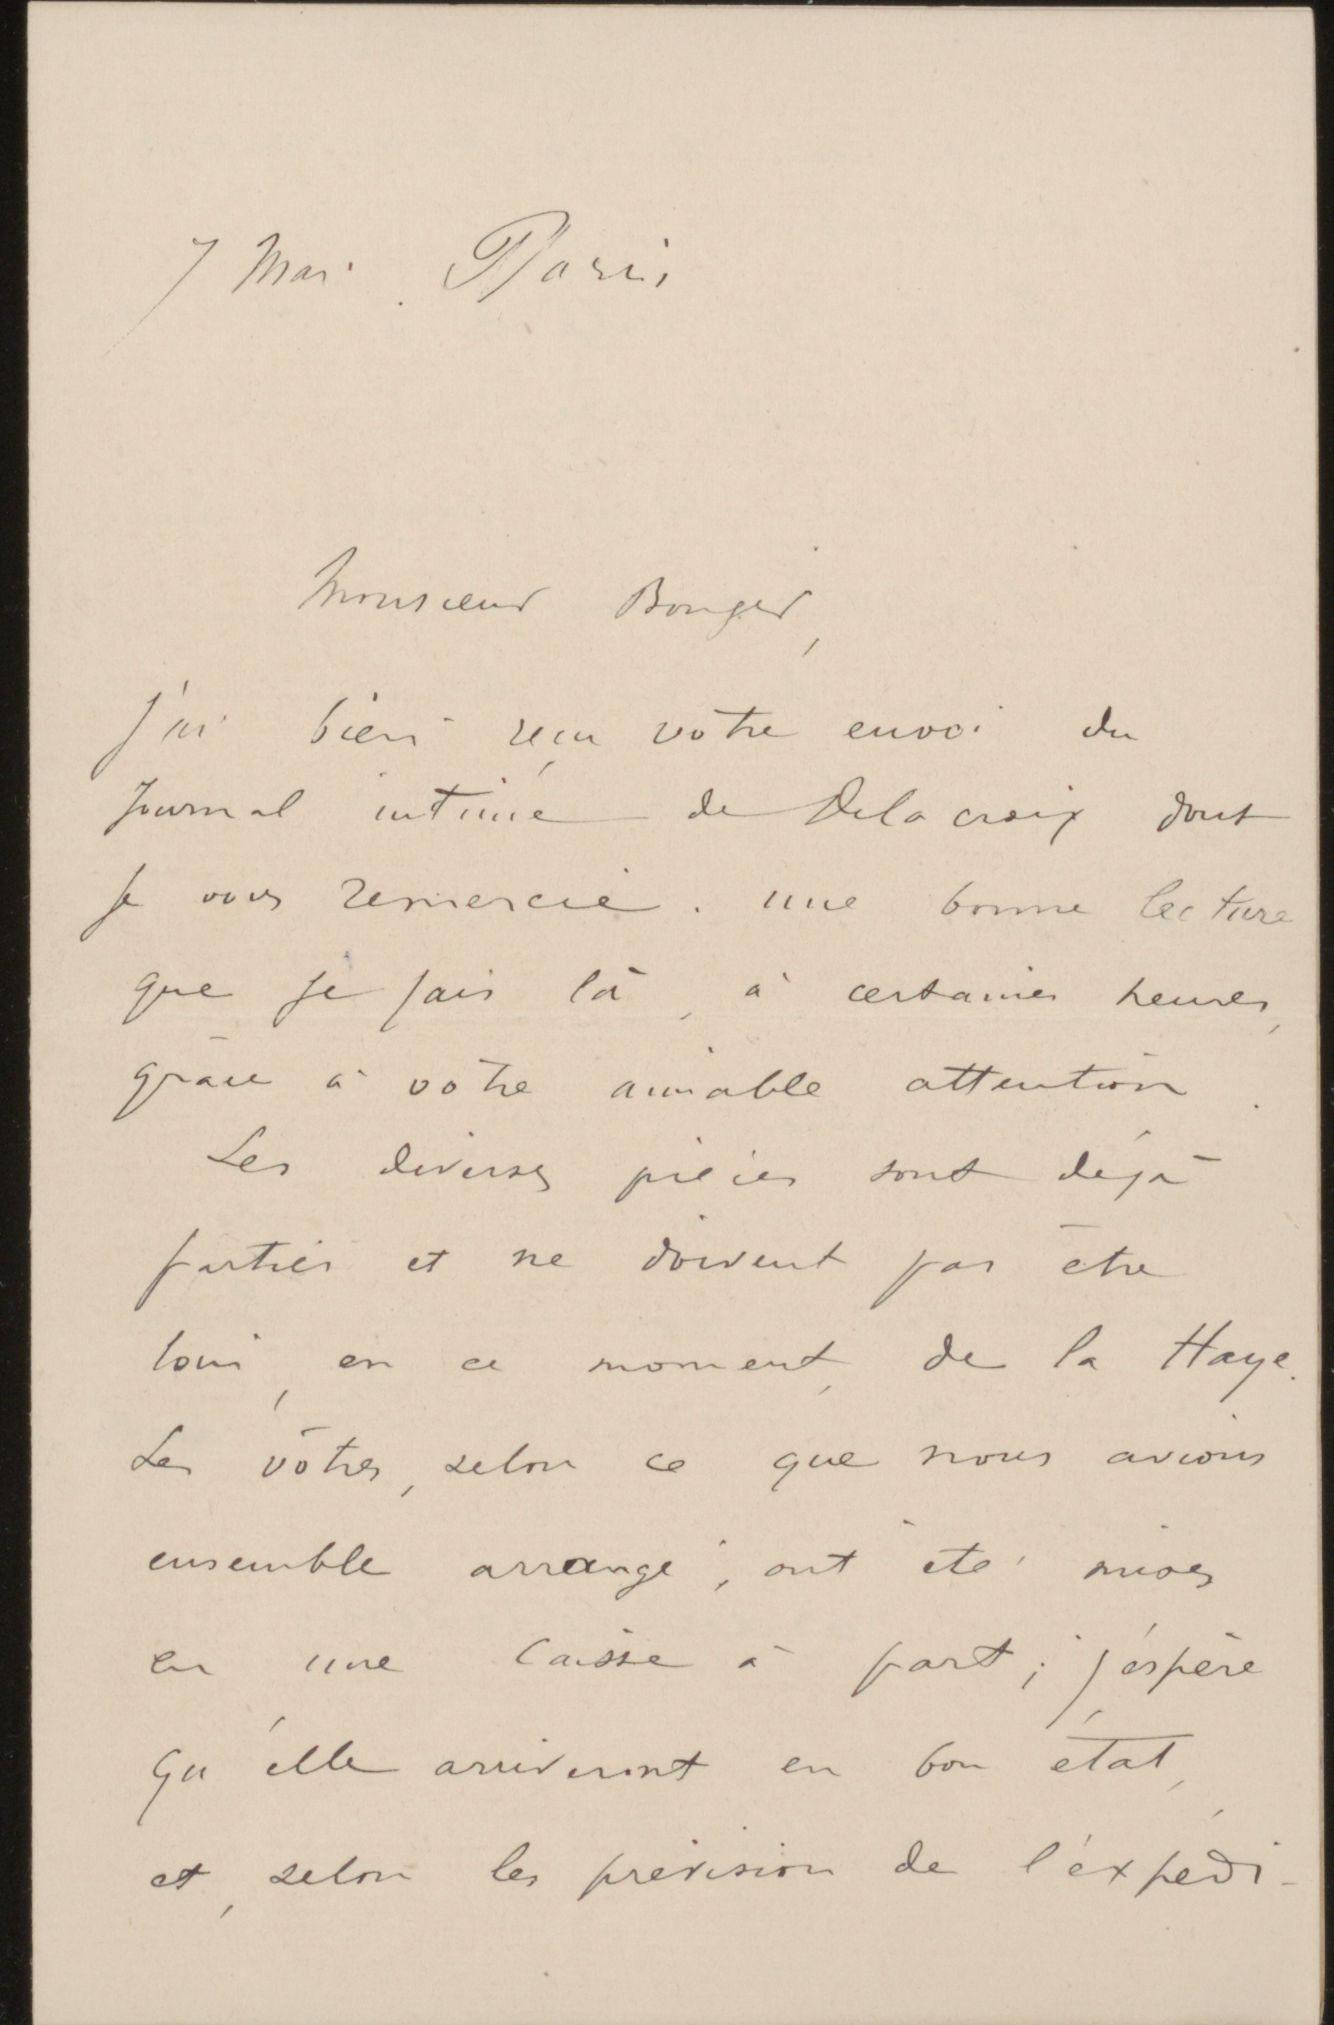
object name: letter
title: Brief aan Andries Bonger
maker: odilon redon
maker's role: draughtsman, painter, print maker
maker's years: 1840-1916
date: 1894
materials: ink, paper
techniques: pen, writing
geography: paris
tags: eugène delacroix, amsterdam, andries bonger, drawing, exhibition ~ art, netherlands, the hague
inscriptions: watermark